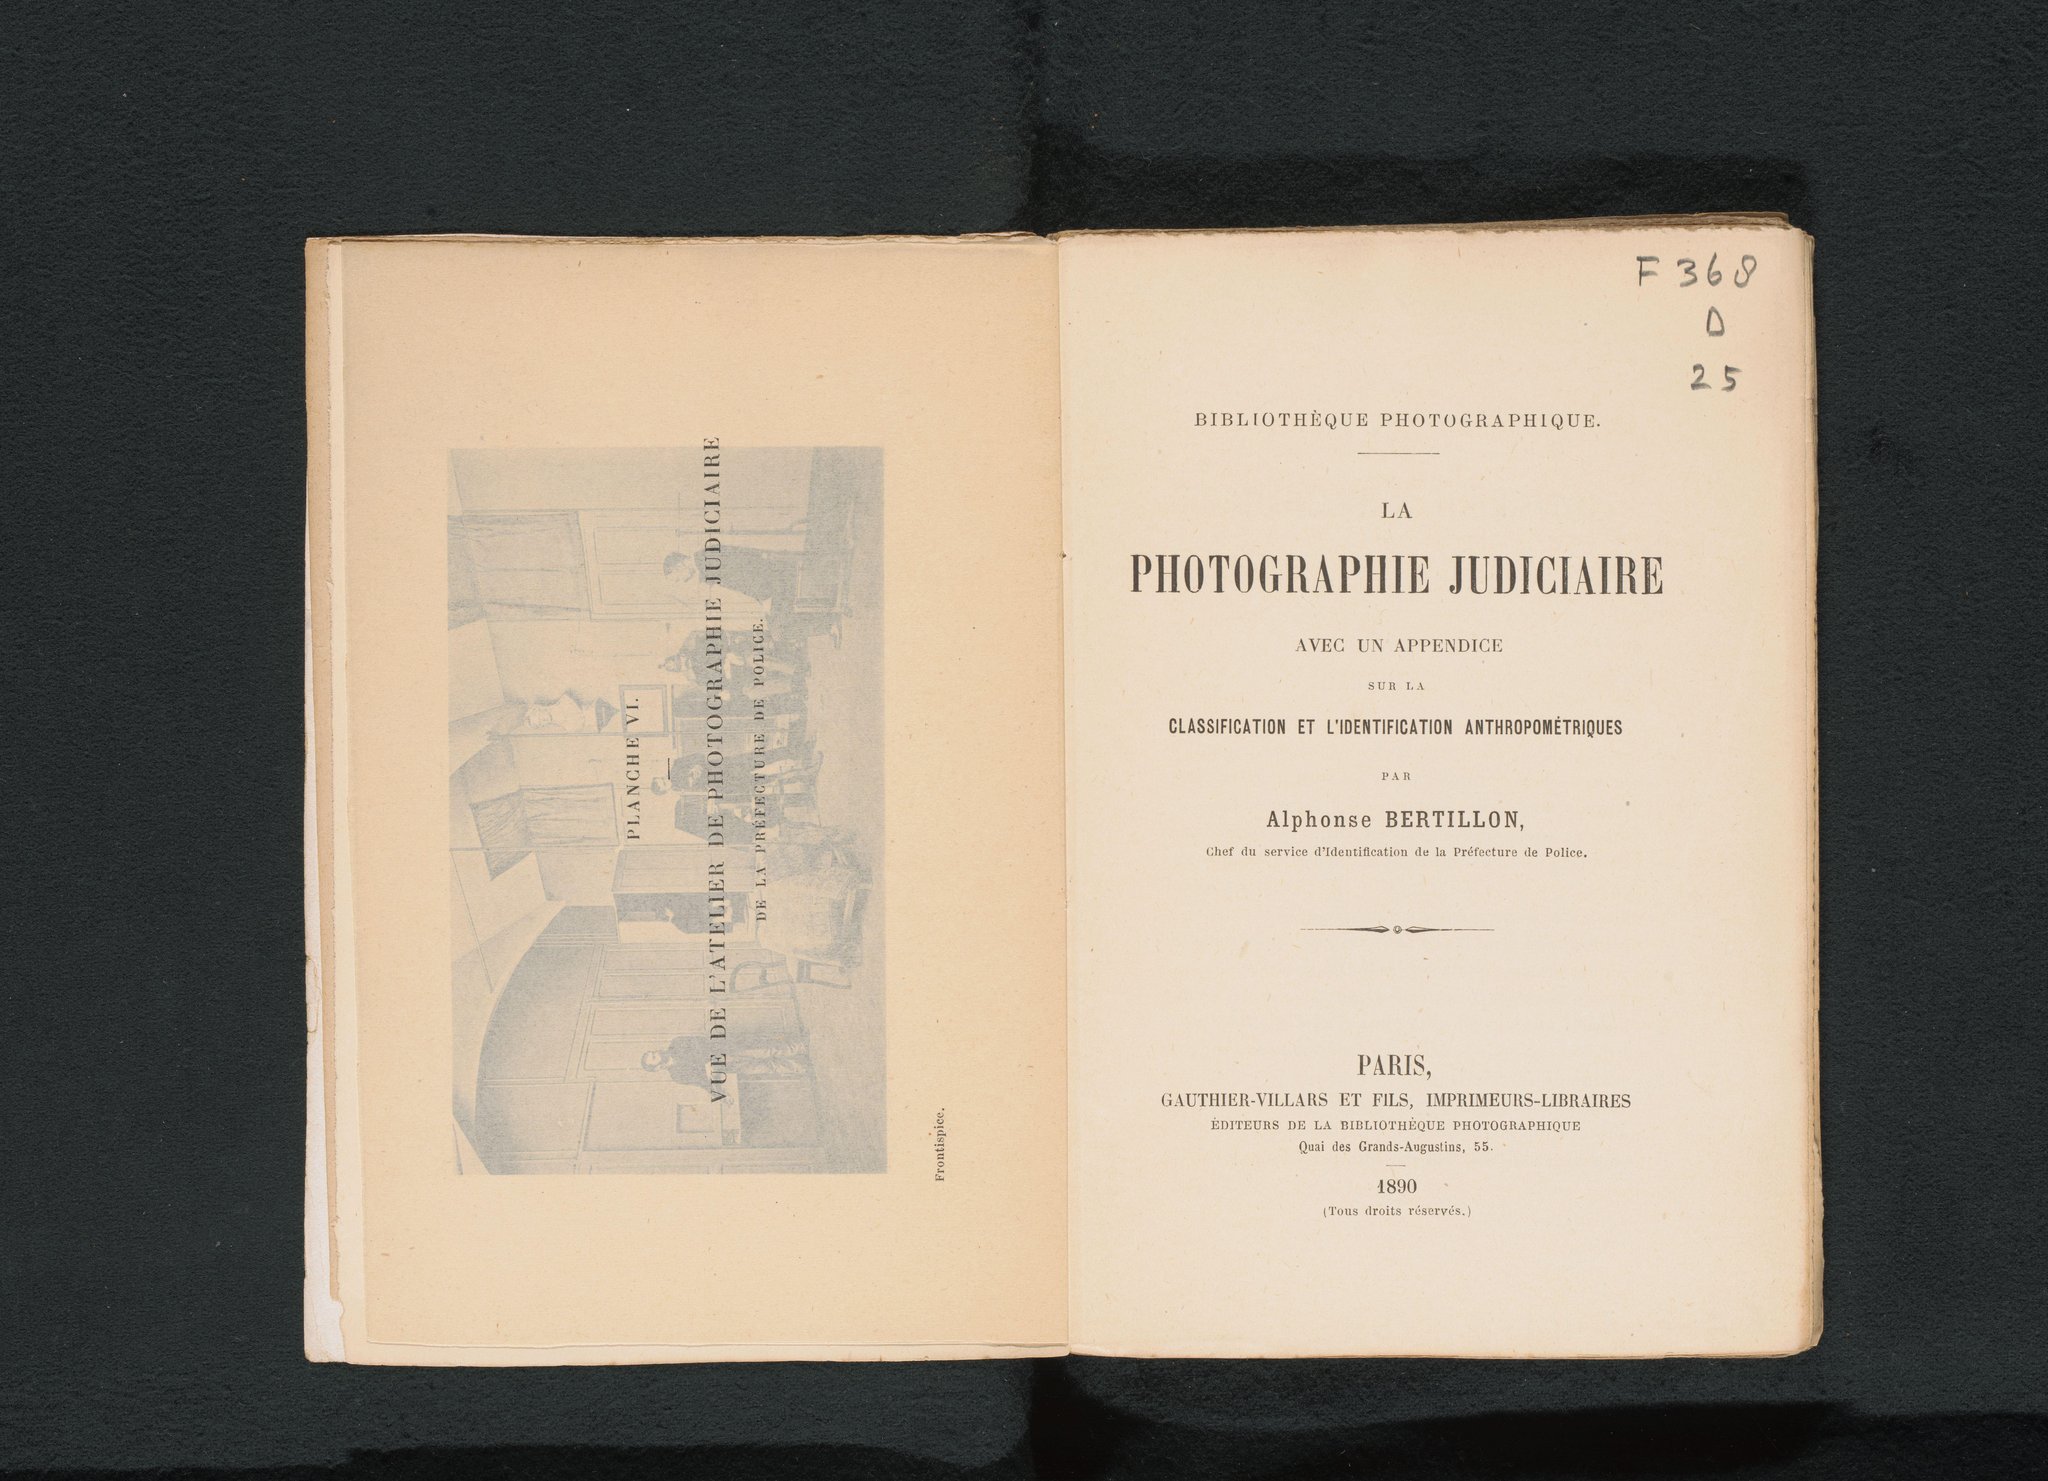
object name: book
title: La photographie judiciaire : avec un appendice sur la classification et l'identification anthropométriques / par Alphonse Bertillon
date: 1890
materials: cardboard, paper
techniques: photograph, printing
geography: paris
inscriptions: date: ‘APR/ 1988’